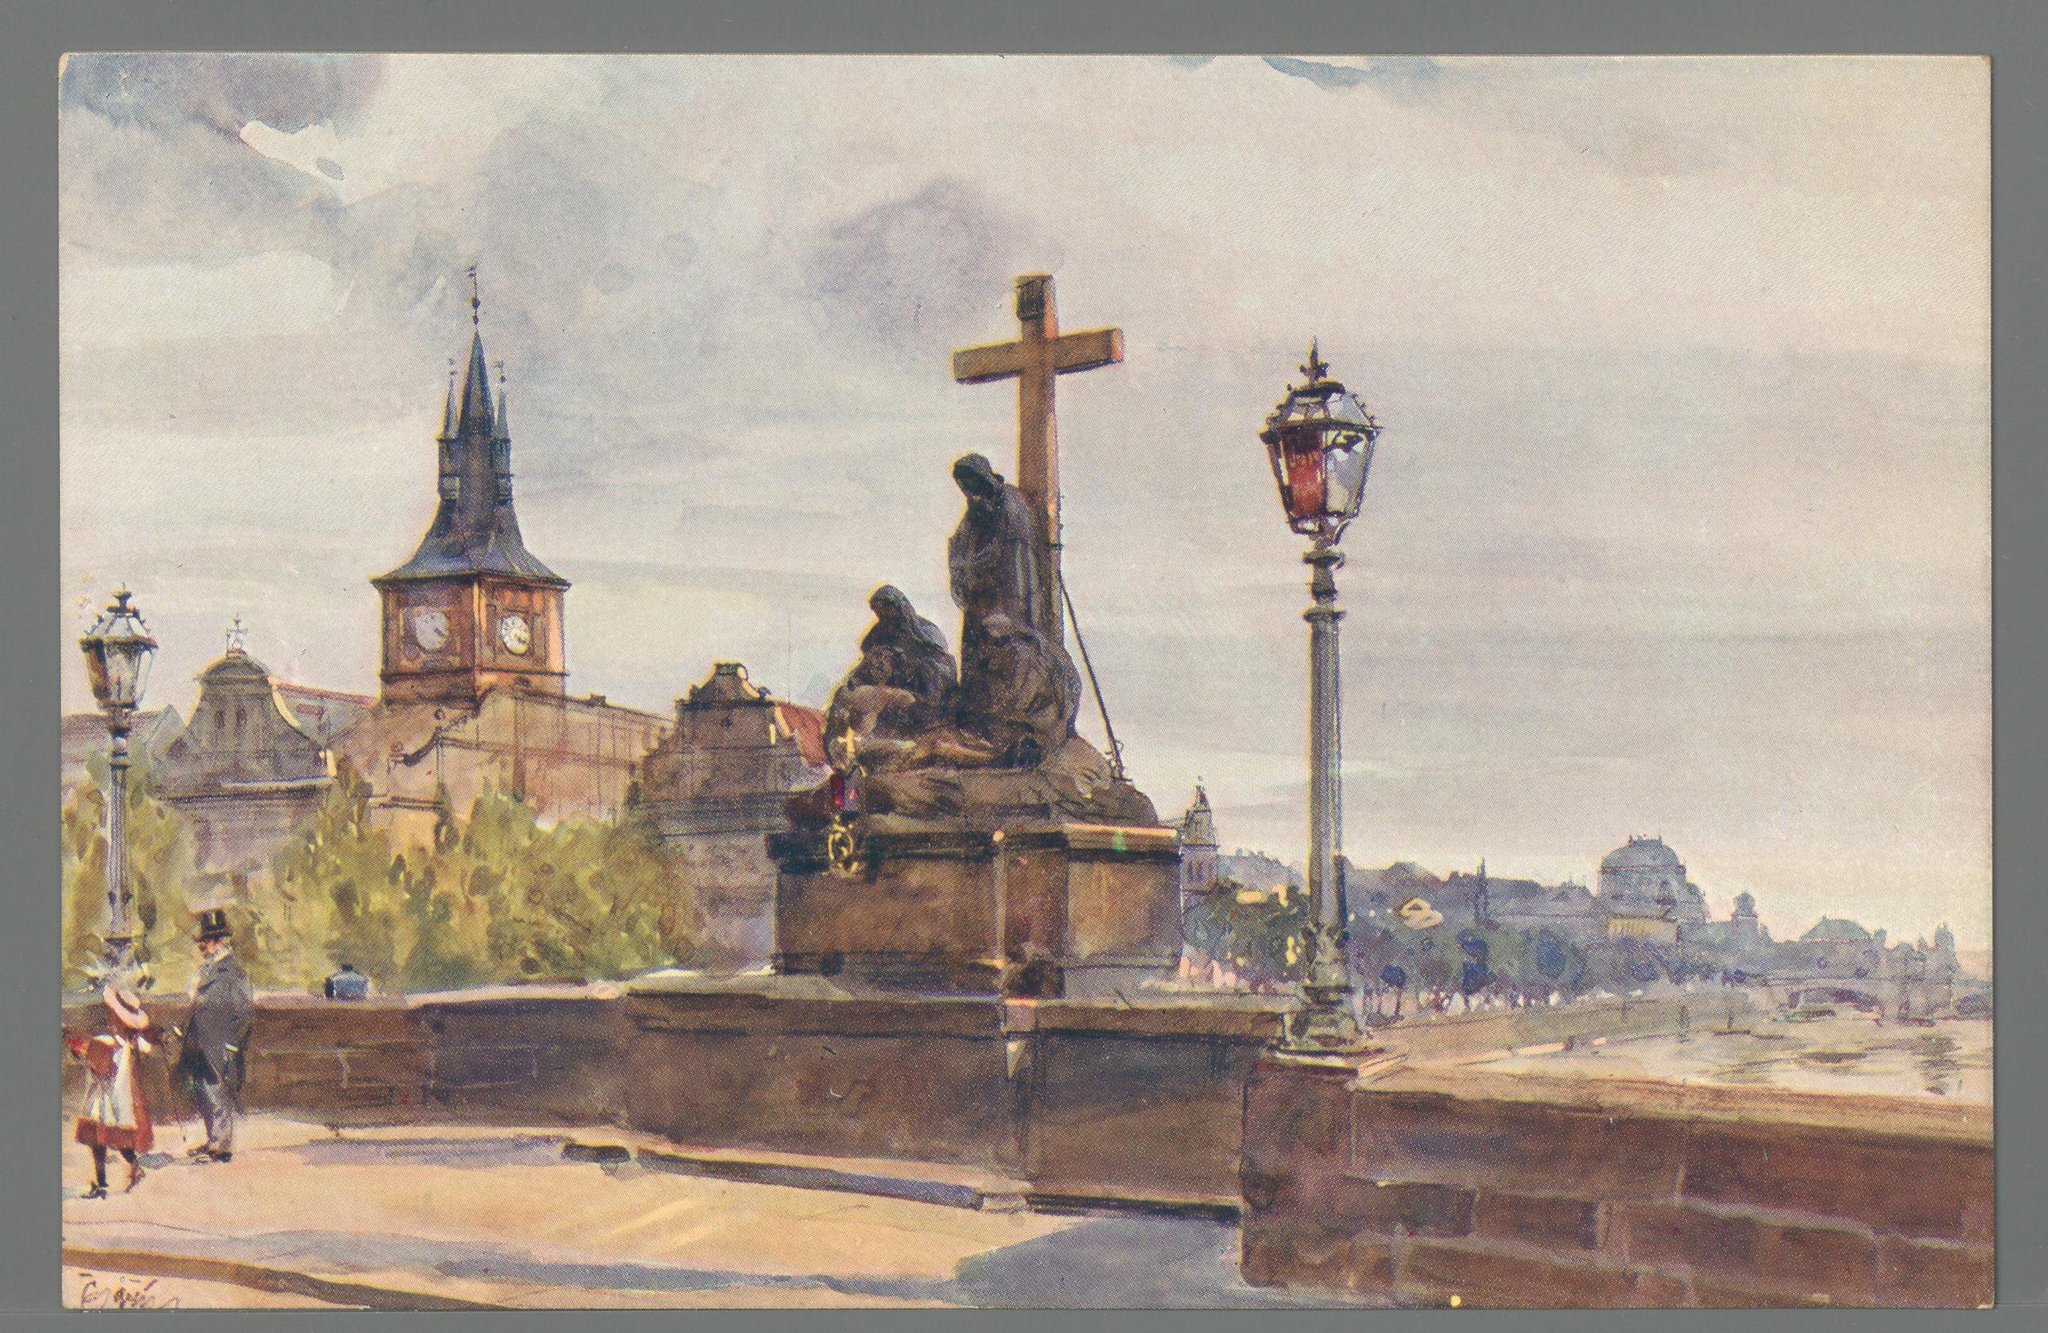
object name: ansichtkaart, prentbriefkaart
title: Na kamenném moste pohled k Národnímu divadlu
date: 1906-1930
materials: cardboard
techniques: color autotype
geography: prague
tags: theatre (building), monument, statue, canals, waters (in city), bridge in city across river, canal, etc.